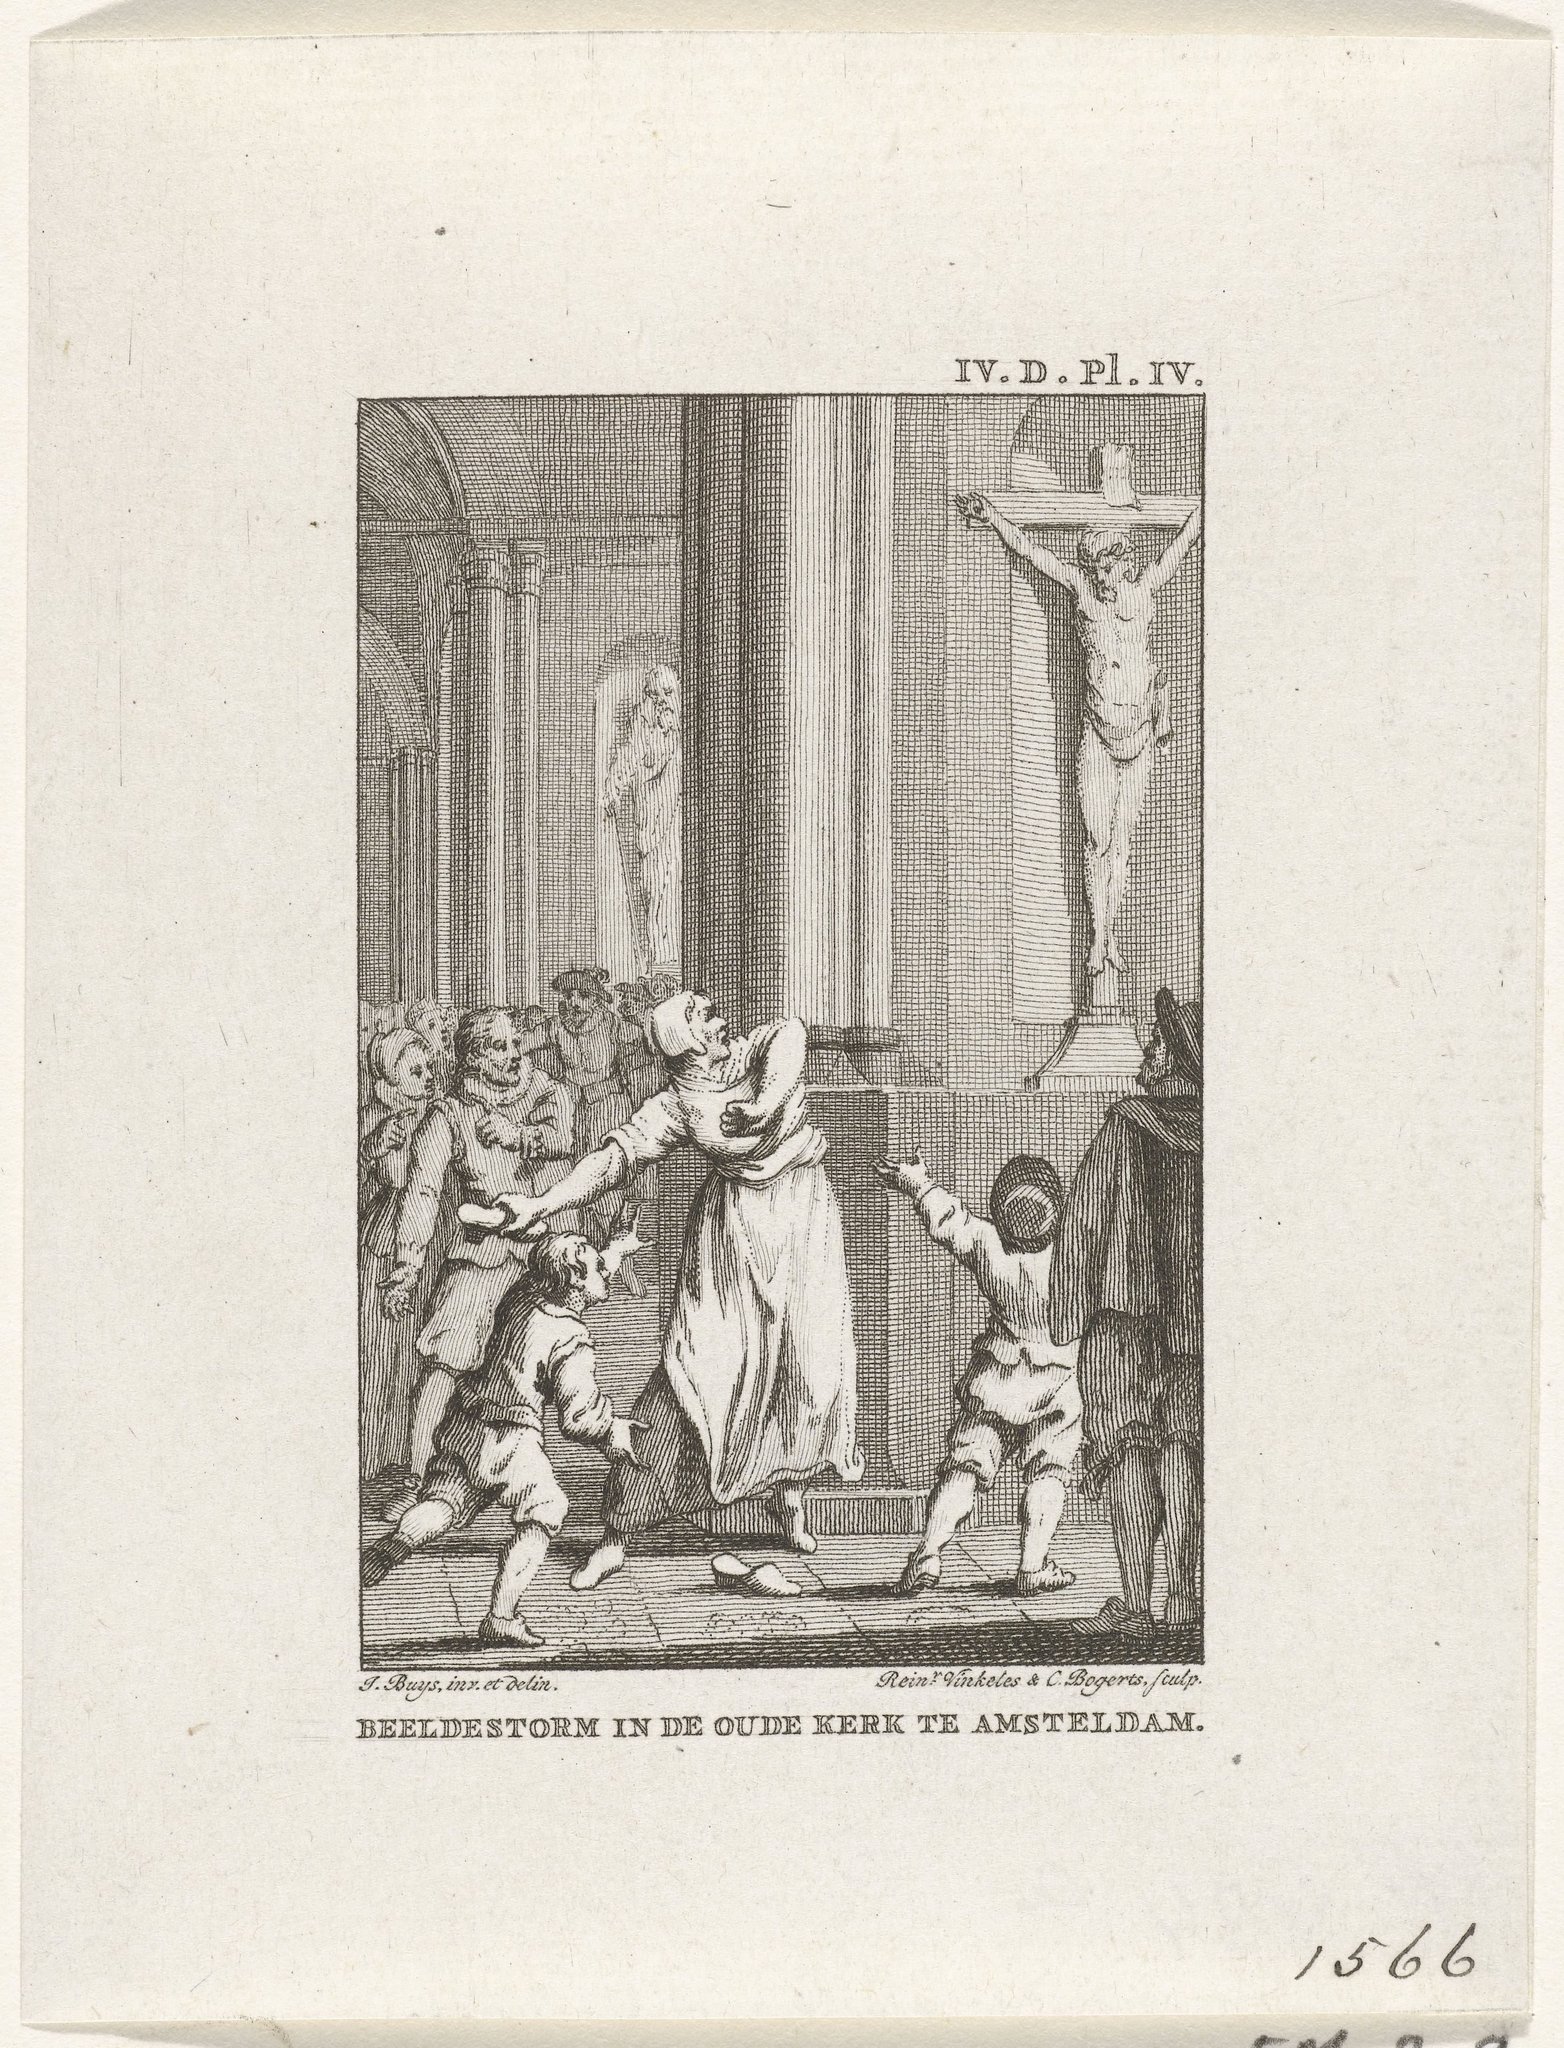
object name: print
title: Beeldestorm in de Oude Kerk te Amsteldam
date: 1780-1795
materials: paper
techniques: etching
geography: netherlands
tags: amsterdam, iconoclasm, beeldenstorm (1566)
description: Illustratie voor: J. Fokke, Geschiedenissen der Vereenigde Nederlanden voor de vaderlandsche jeugd, Johannes Allart, Amsterdam 1783-1795, 25 delen, dl. IV, pl. IV. Staat met de letter.